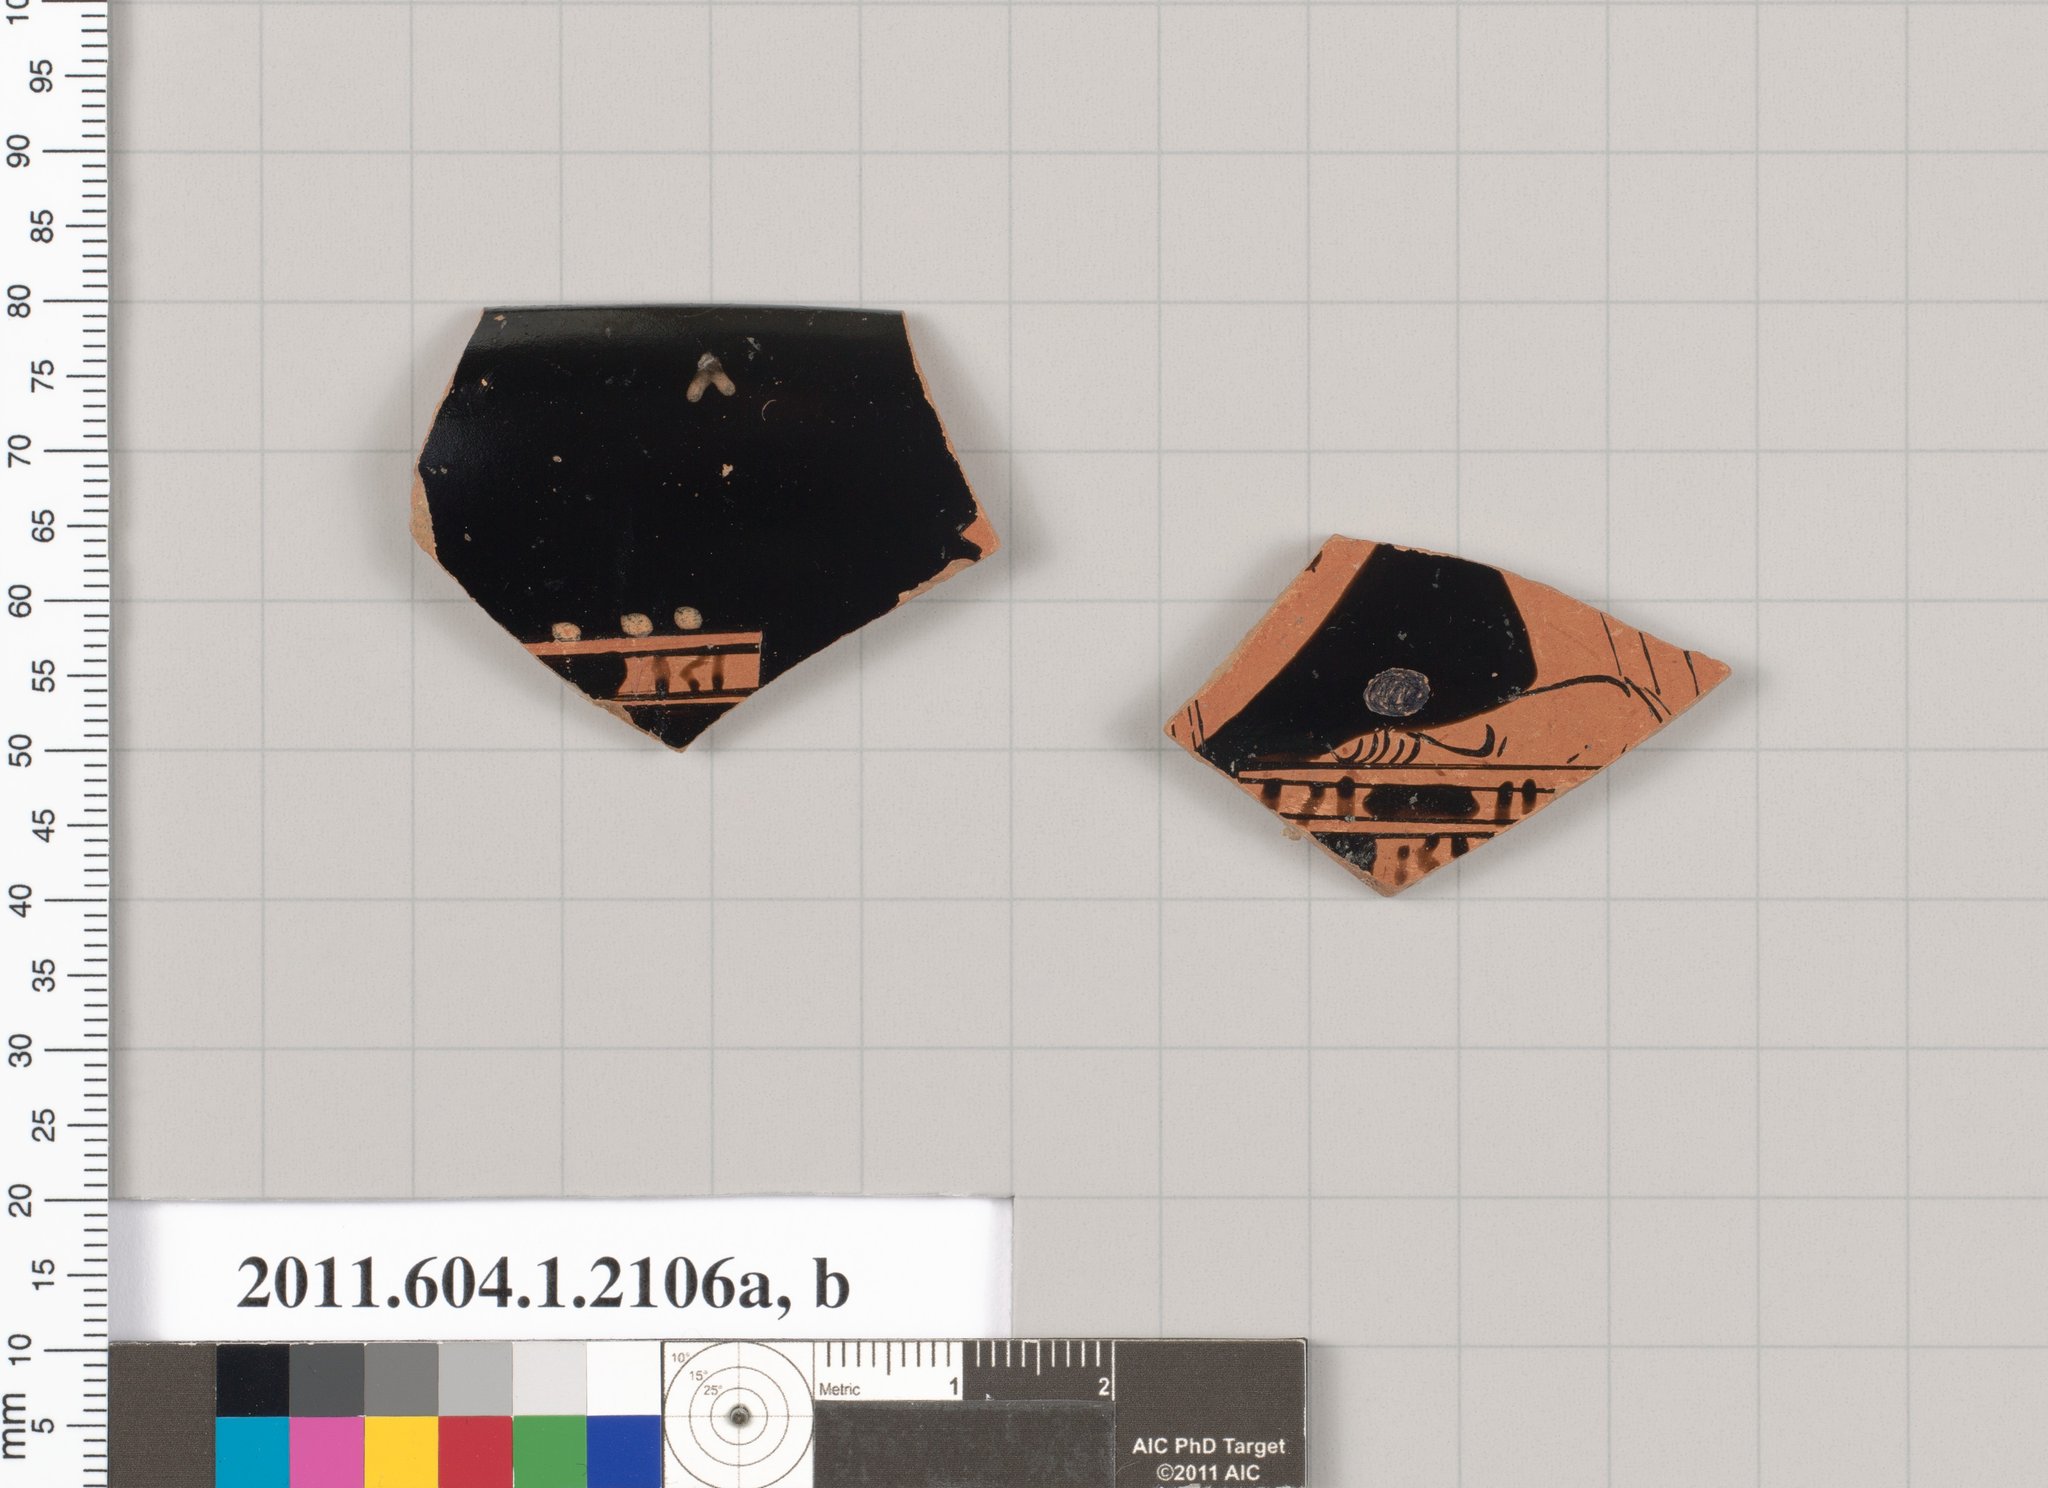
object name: kylix fragment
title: Terracotta fragments of a kylix (drinking cup)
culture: greek, attic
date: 467-435 BCE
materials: terracotta